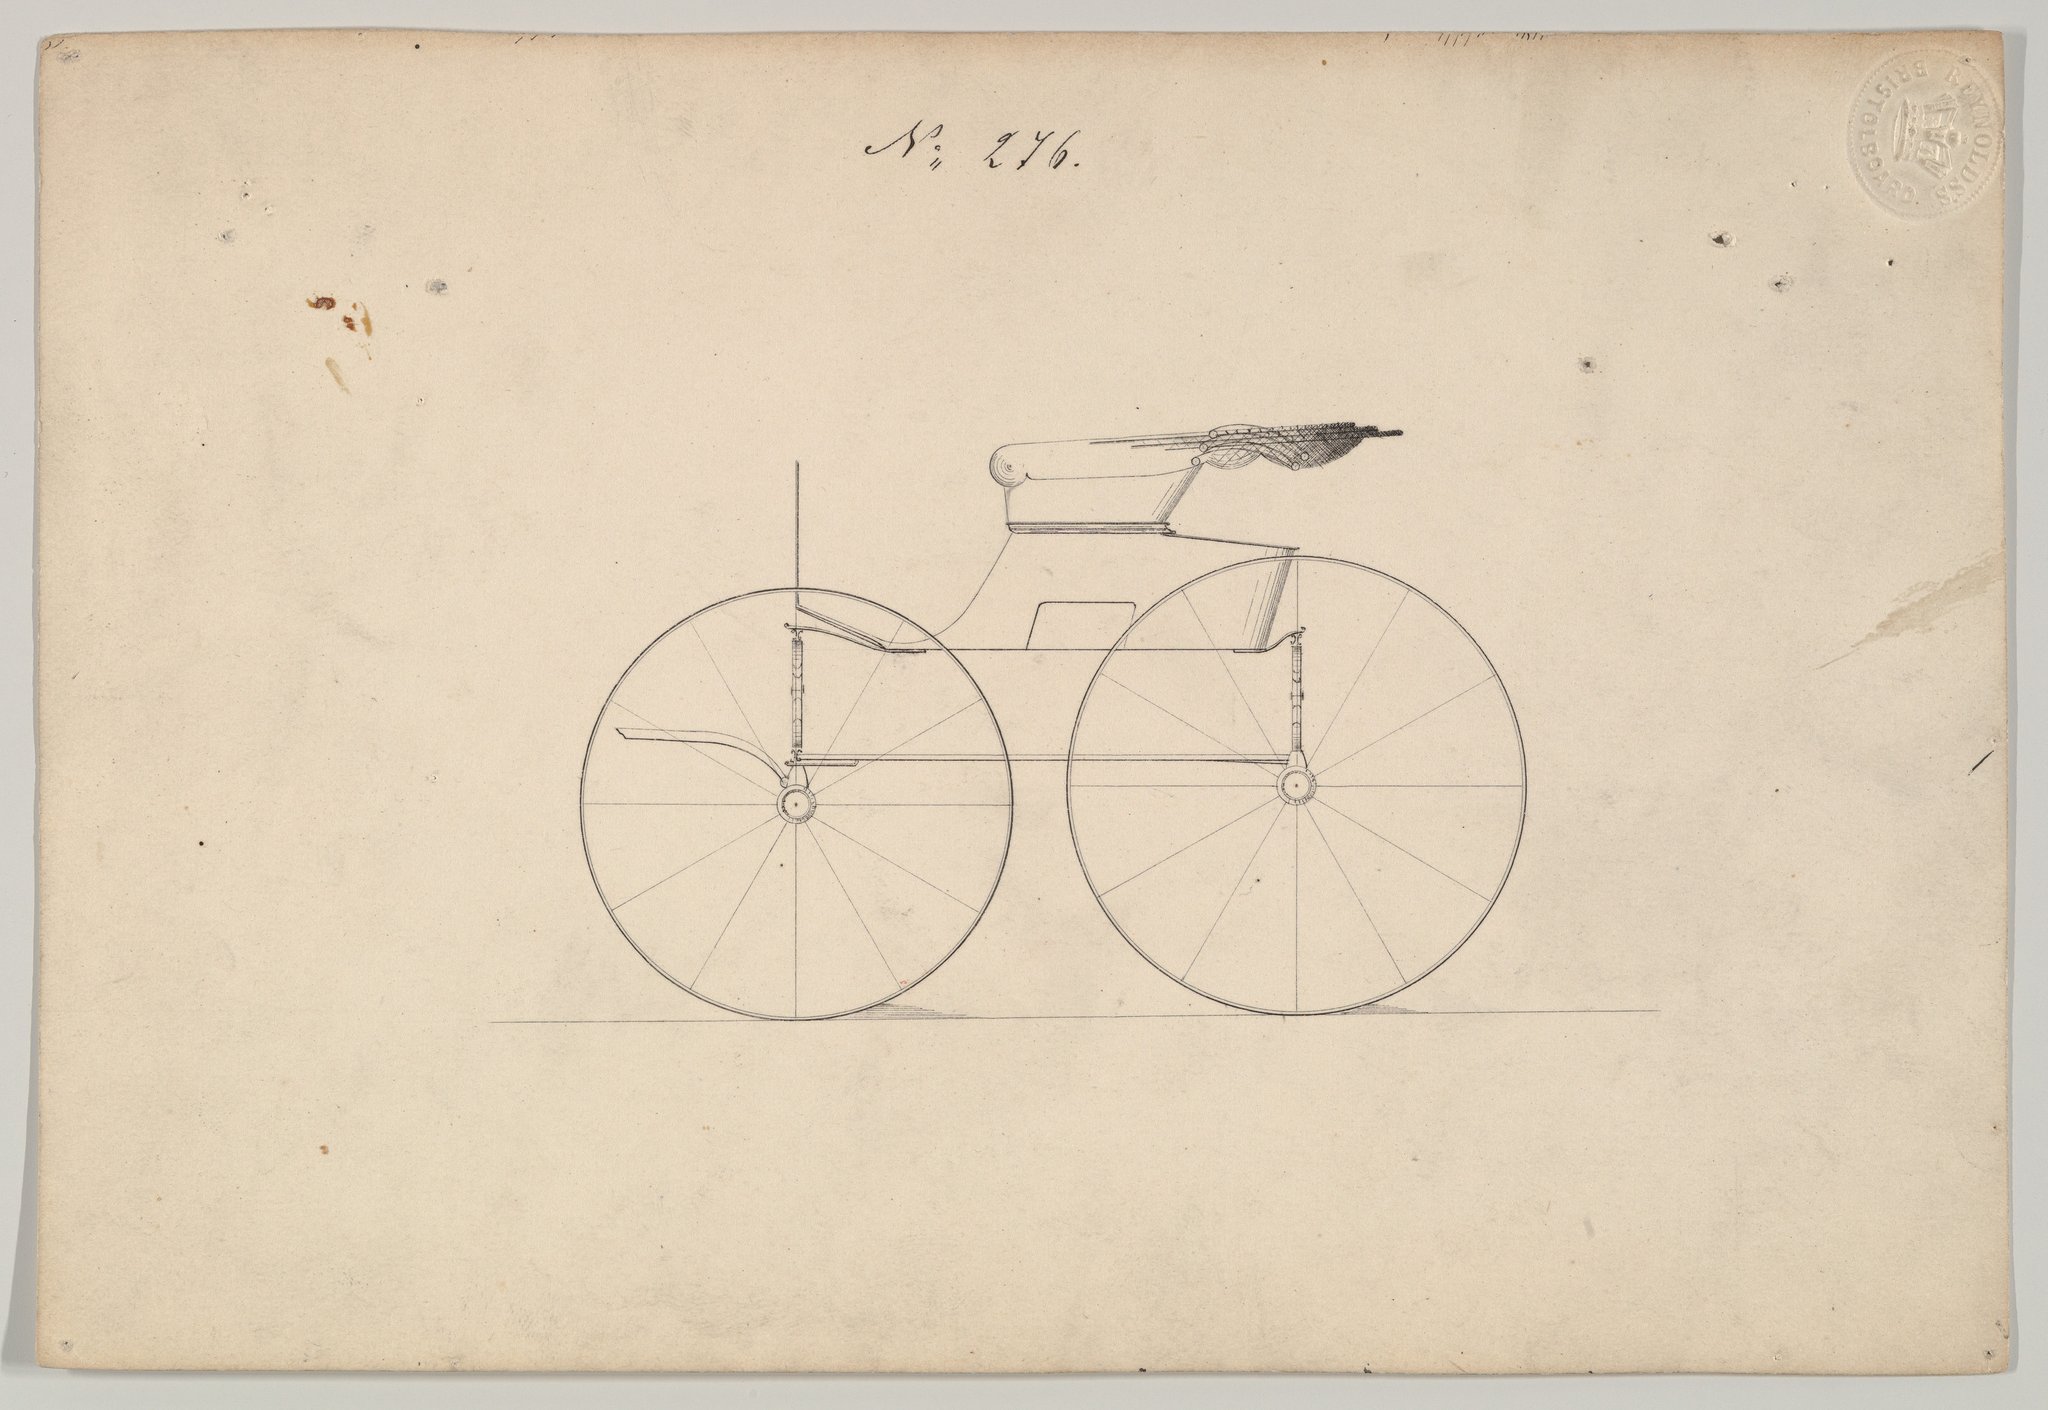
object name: drawing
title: Wagon #276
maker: brewster & co.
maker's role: manufacturer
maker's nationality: american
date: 1865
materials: ink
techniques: pen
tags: carriages